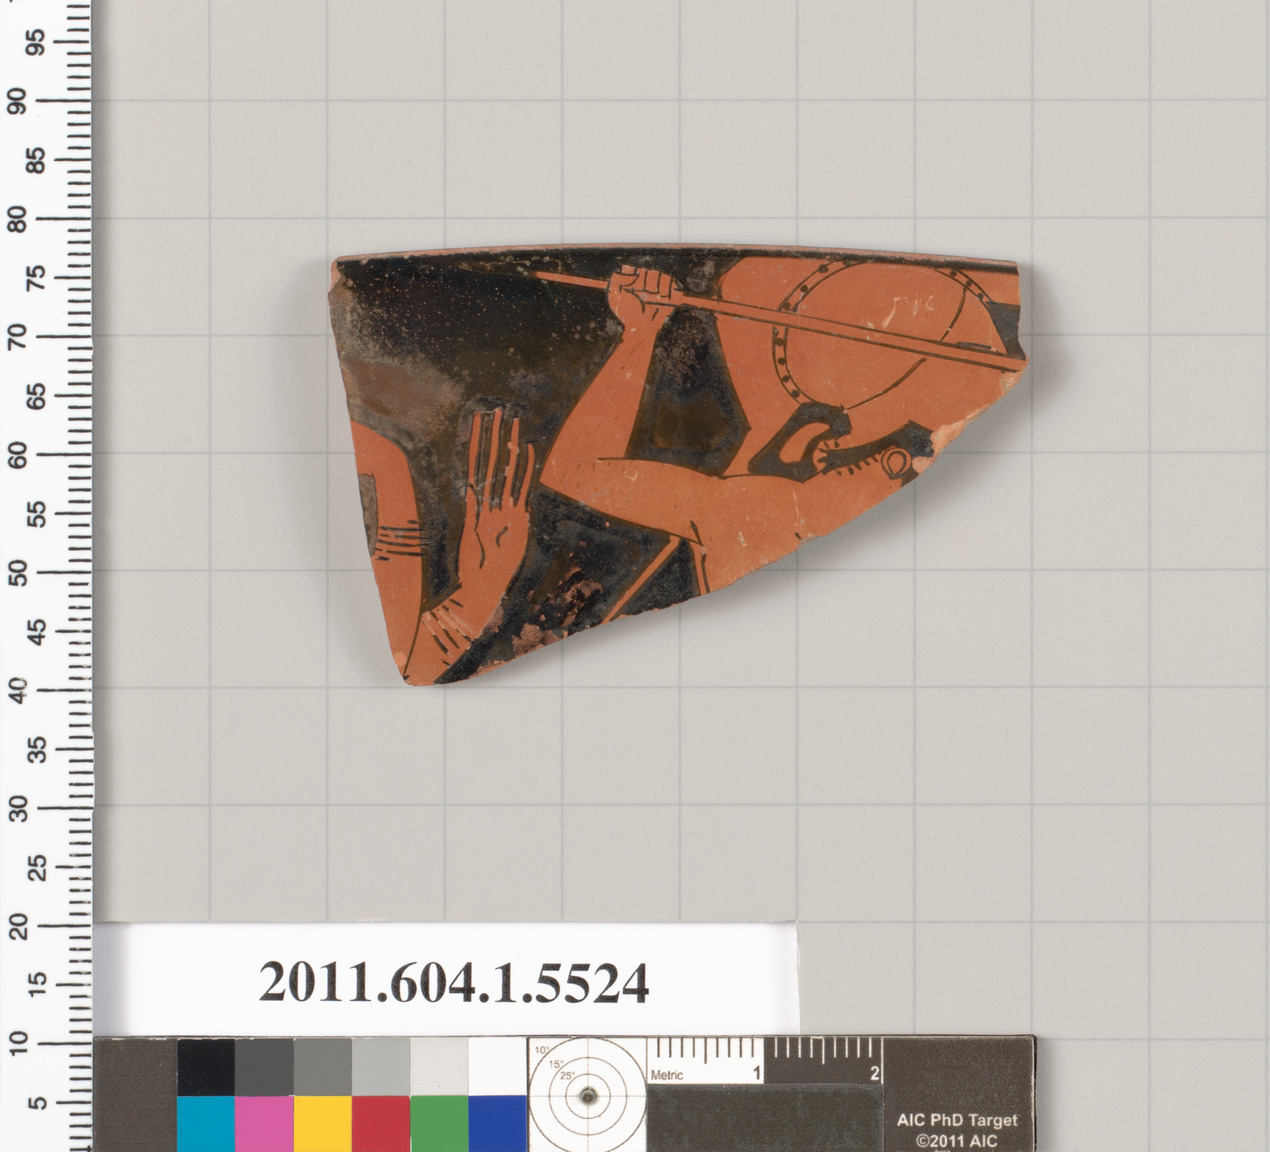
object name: kylix fragment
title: Terracotta rim fragment of a kylix (drinking cup)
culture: greek, attic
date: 500-490 BCE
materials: terracotta